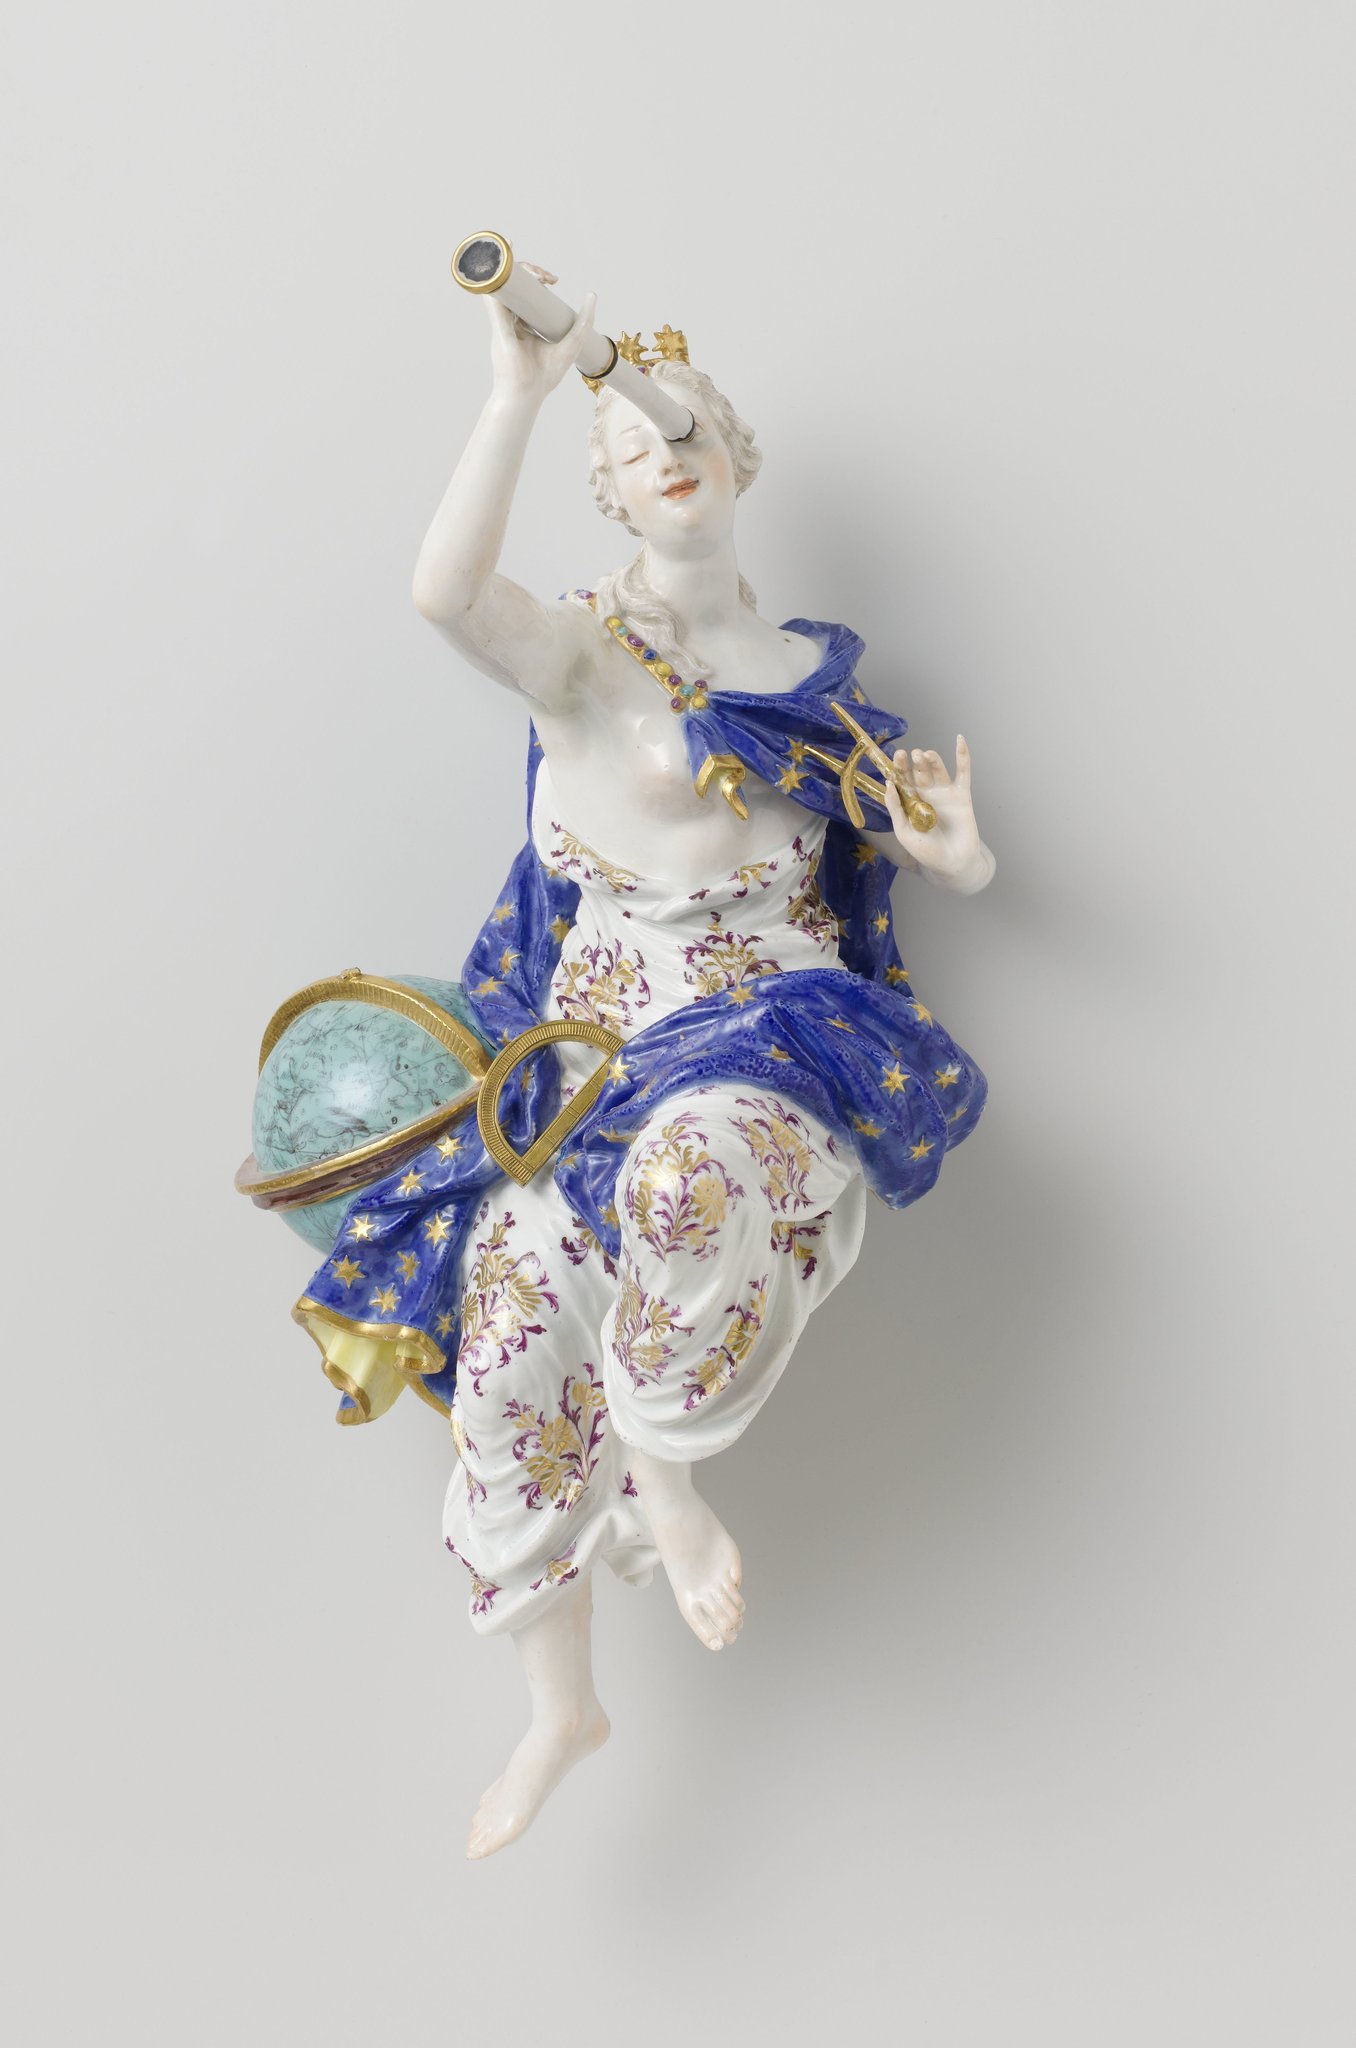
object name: figure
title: De muze Urania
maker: johann joachim kändler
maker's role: designer, sculptor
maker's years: 1706-1775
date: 1748-1750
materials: bronze, porcelain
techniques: gilding, painted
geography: meissen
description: Urania. Porcelain. Meissen, c. 1745 - 1750, the model by Johann Joachim Kändler. This figure belonged to the large ornamental mirror which Augustus III of Saxony presented to his son-in-law, Louis XV of France. The mirror and the console table belonging to it were taken to Paris in 1750 by Kändler himself. Given by the Commissie voor Fotoverkoop, 1964.